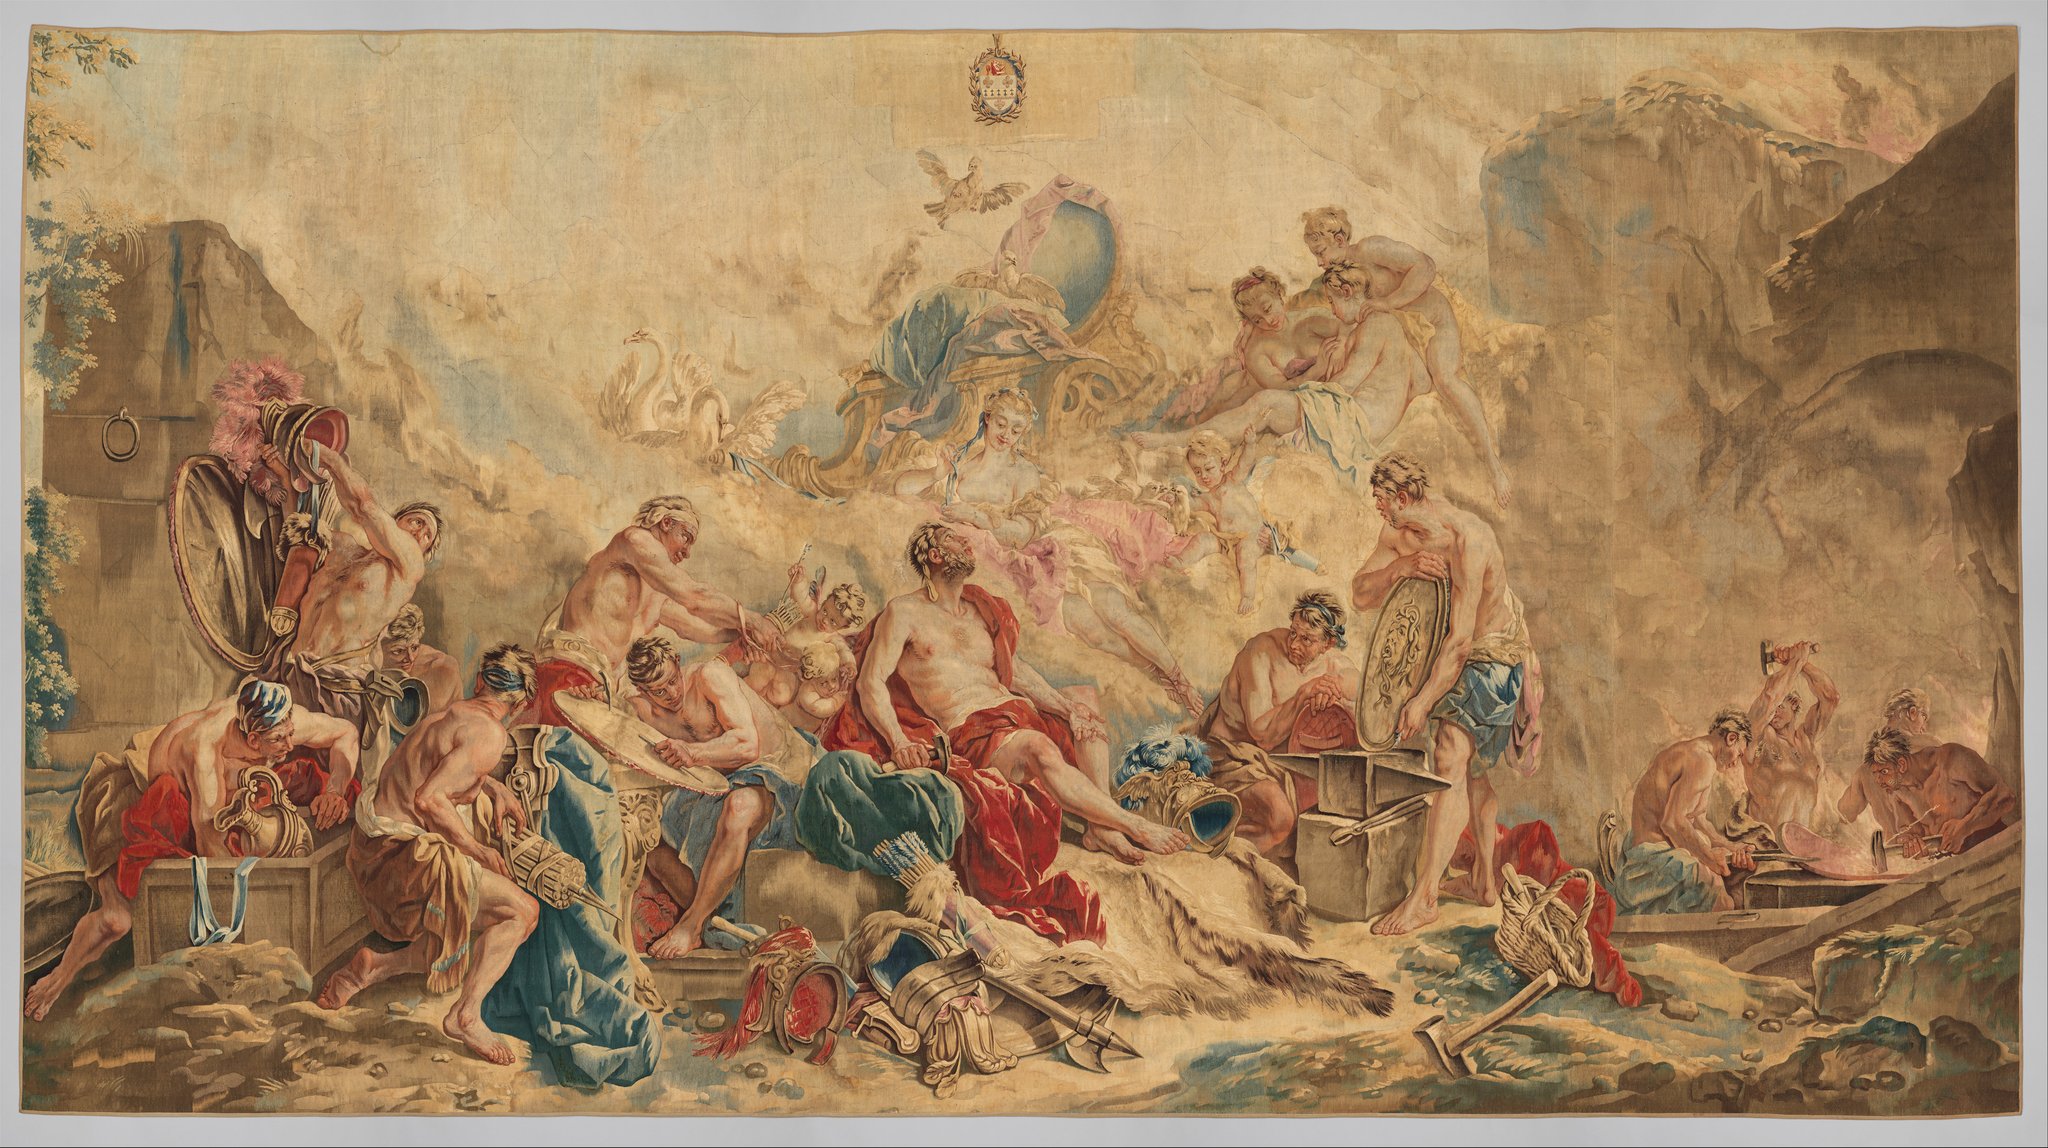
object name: tapestry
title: Vulcan Presenting Arms for Aeneas to Venus from the set The Loves of the Gods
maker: françois boucher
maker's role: artist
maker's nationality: french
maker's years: 1703-1770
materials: silk, wool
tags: men,aeneas,venus,vulcan,swans